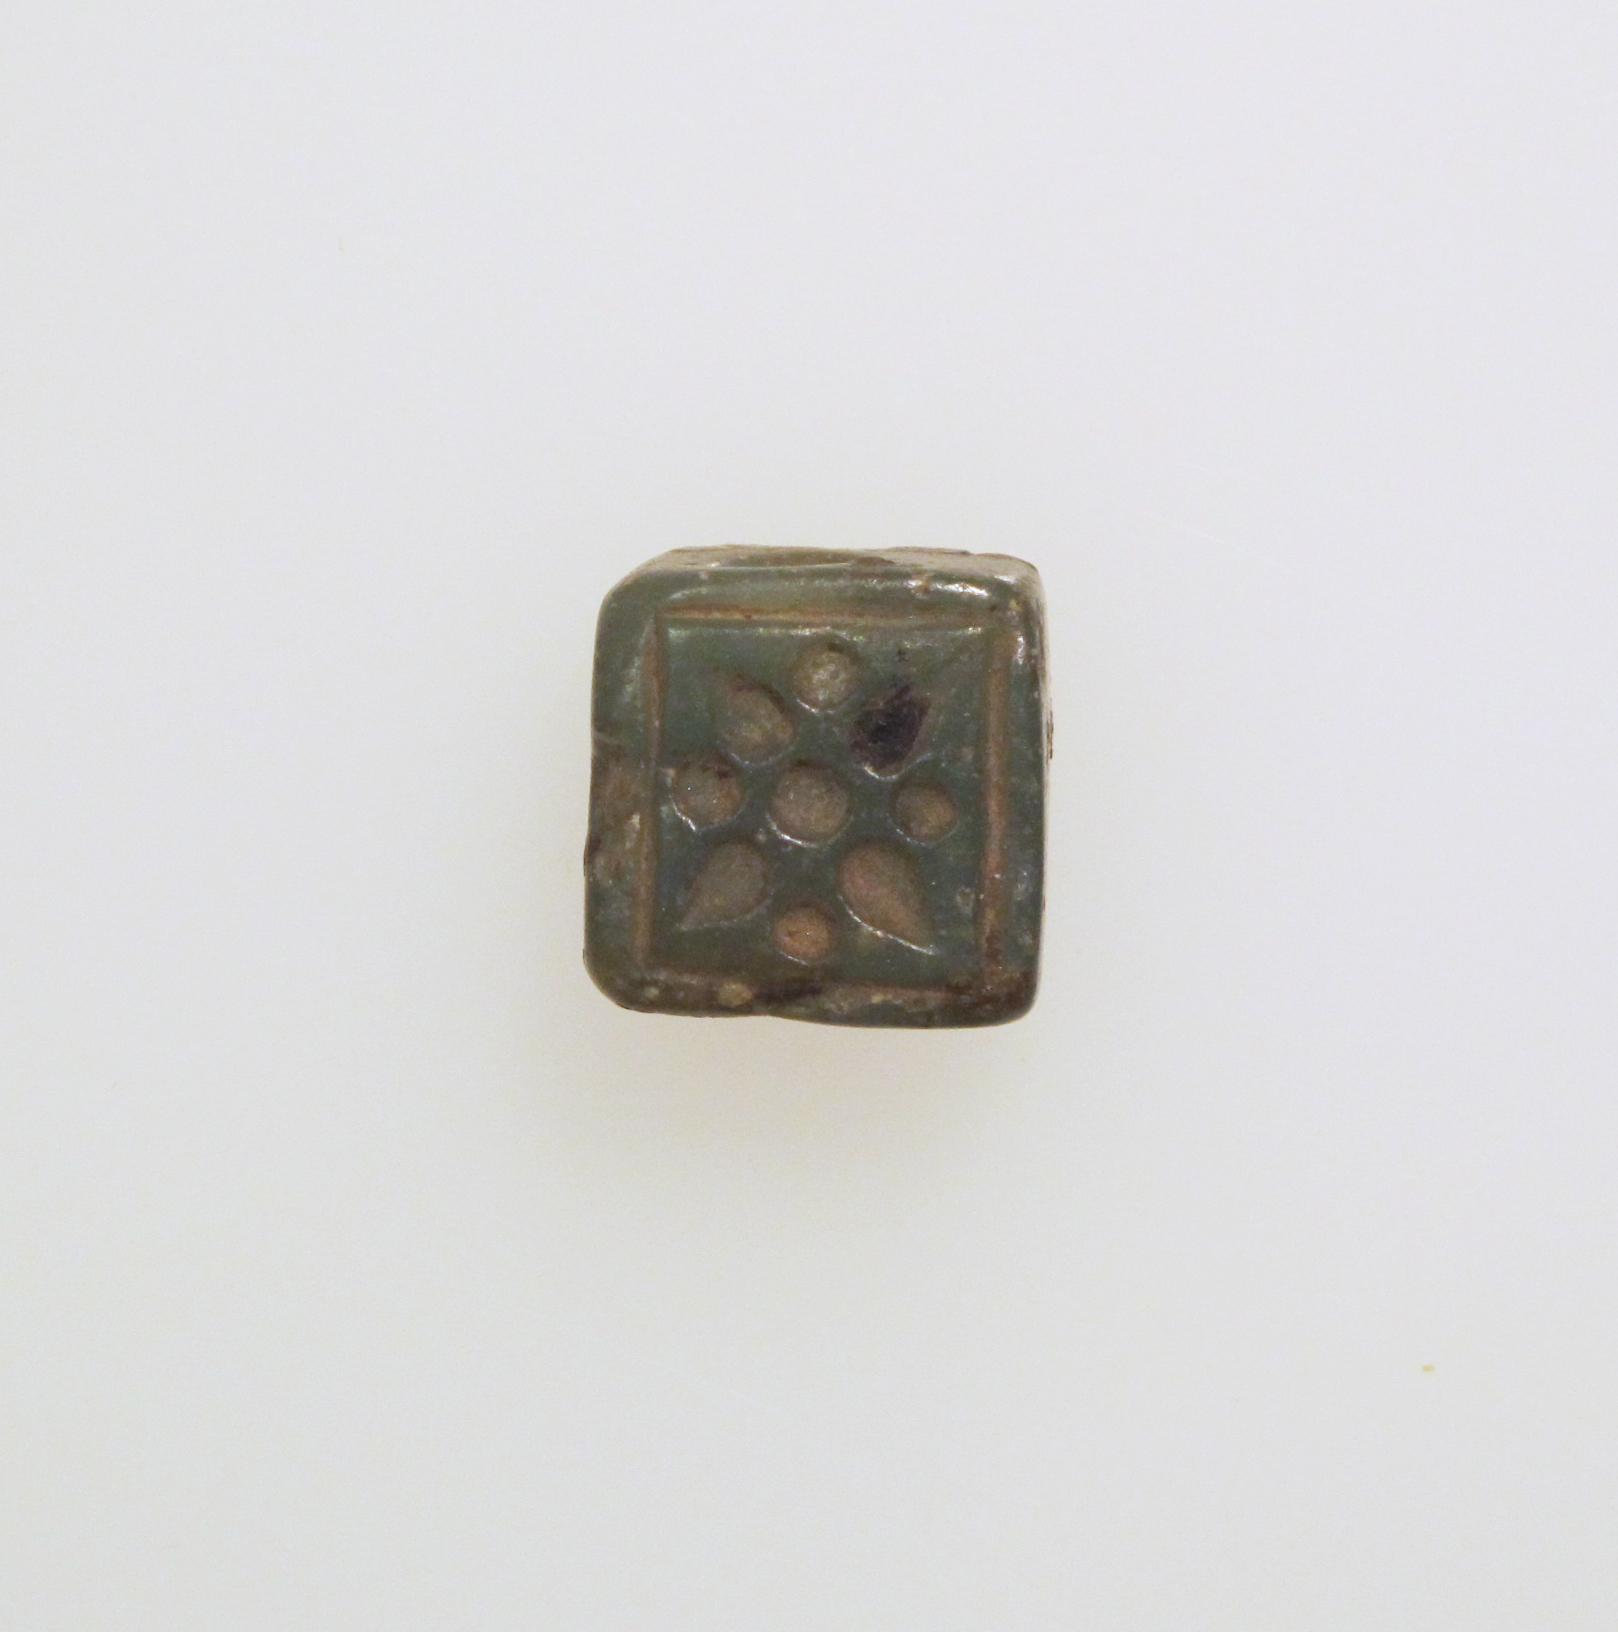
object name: pendant in the form of a dolphin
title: Glass pendant with dolphins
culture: roman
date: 670 BCE-330 CE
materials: glass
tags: dolphins